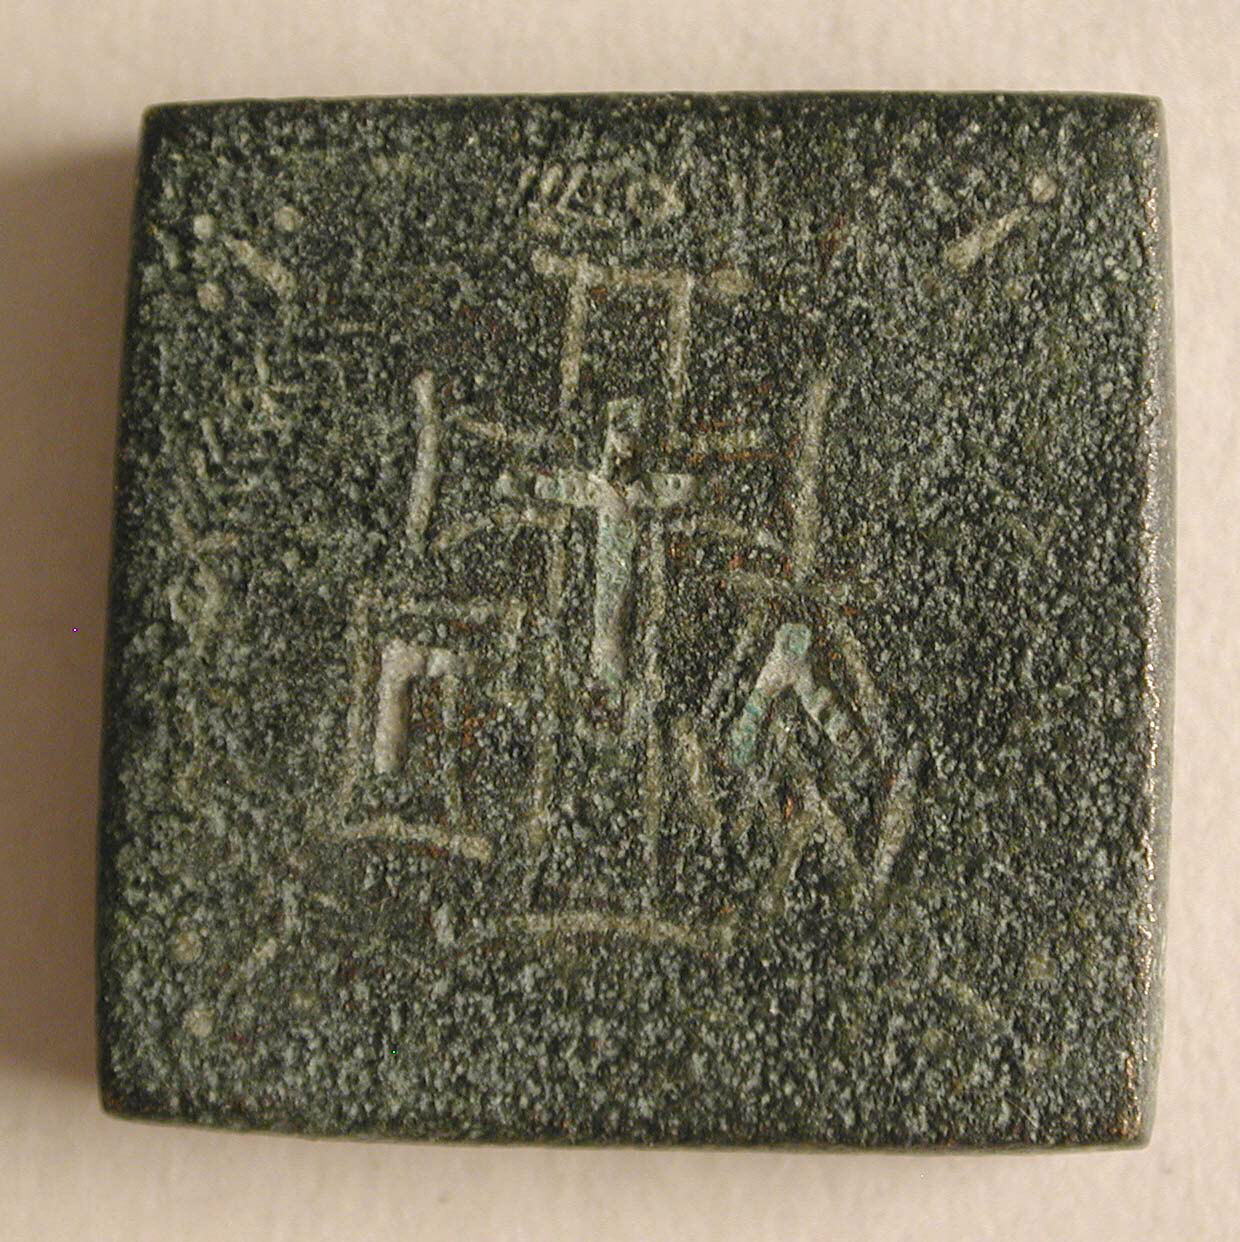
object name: weight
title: Copper-Alloy Balance Weight with a Cross in a Wreath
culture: byzantine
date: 401-600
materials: copper alloy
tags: wreaths,cross